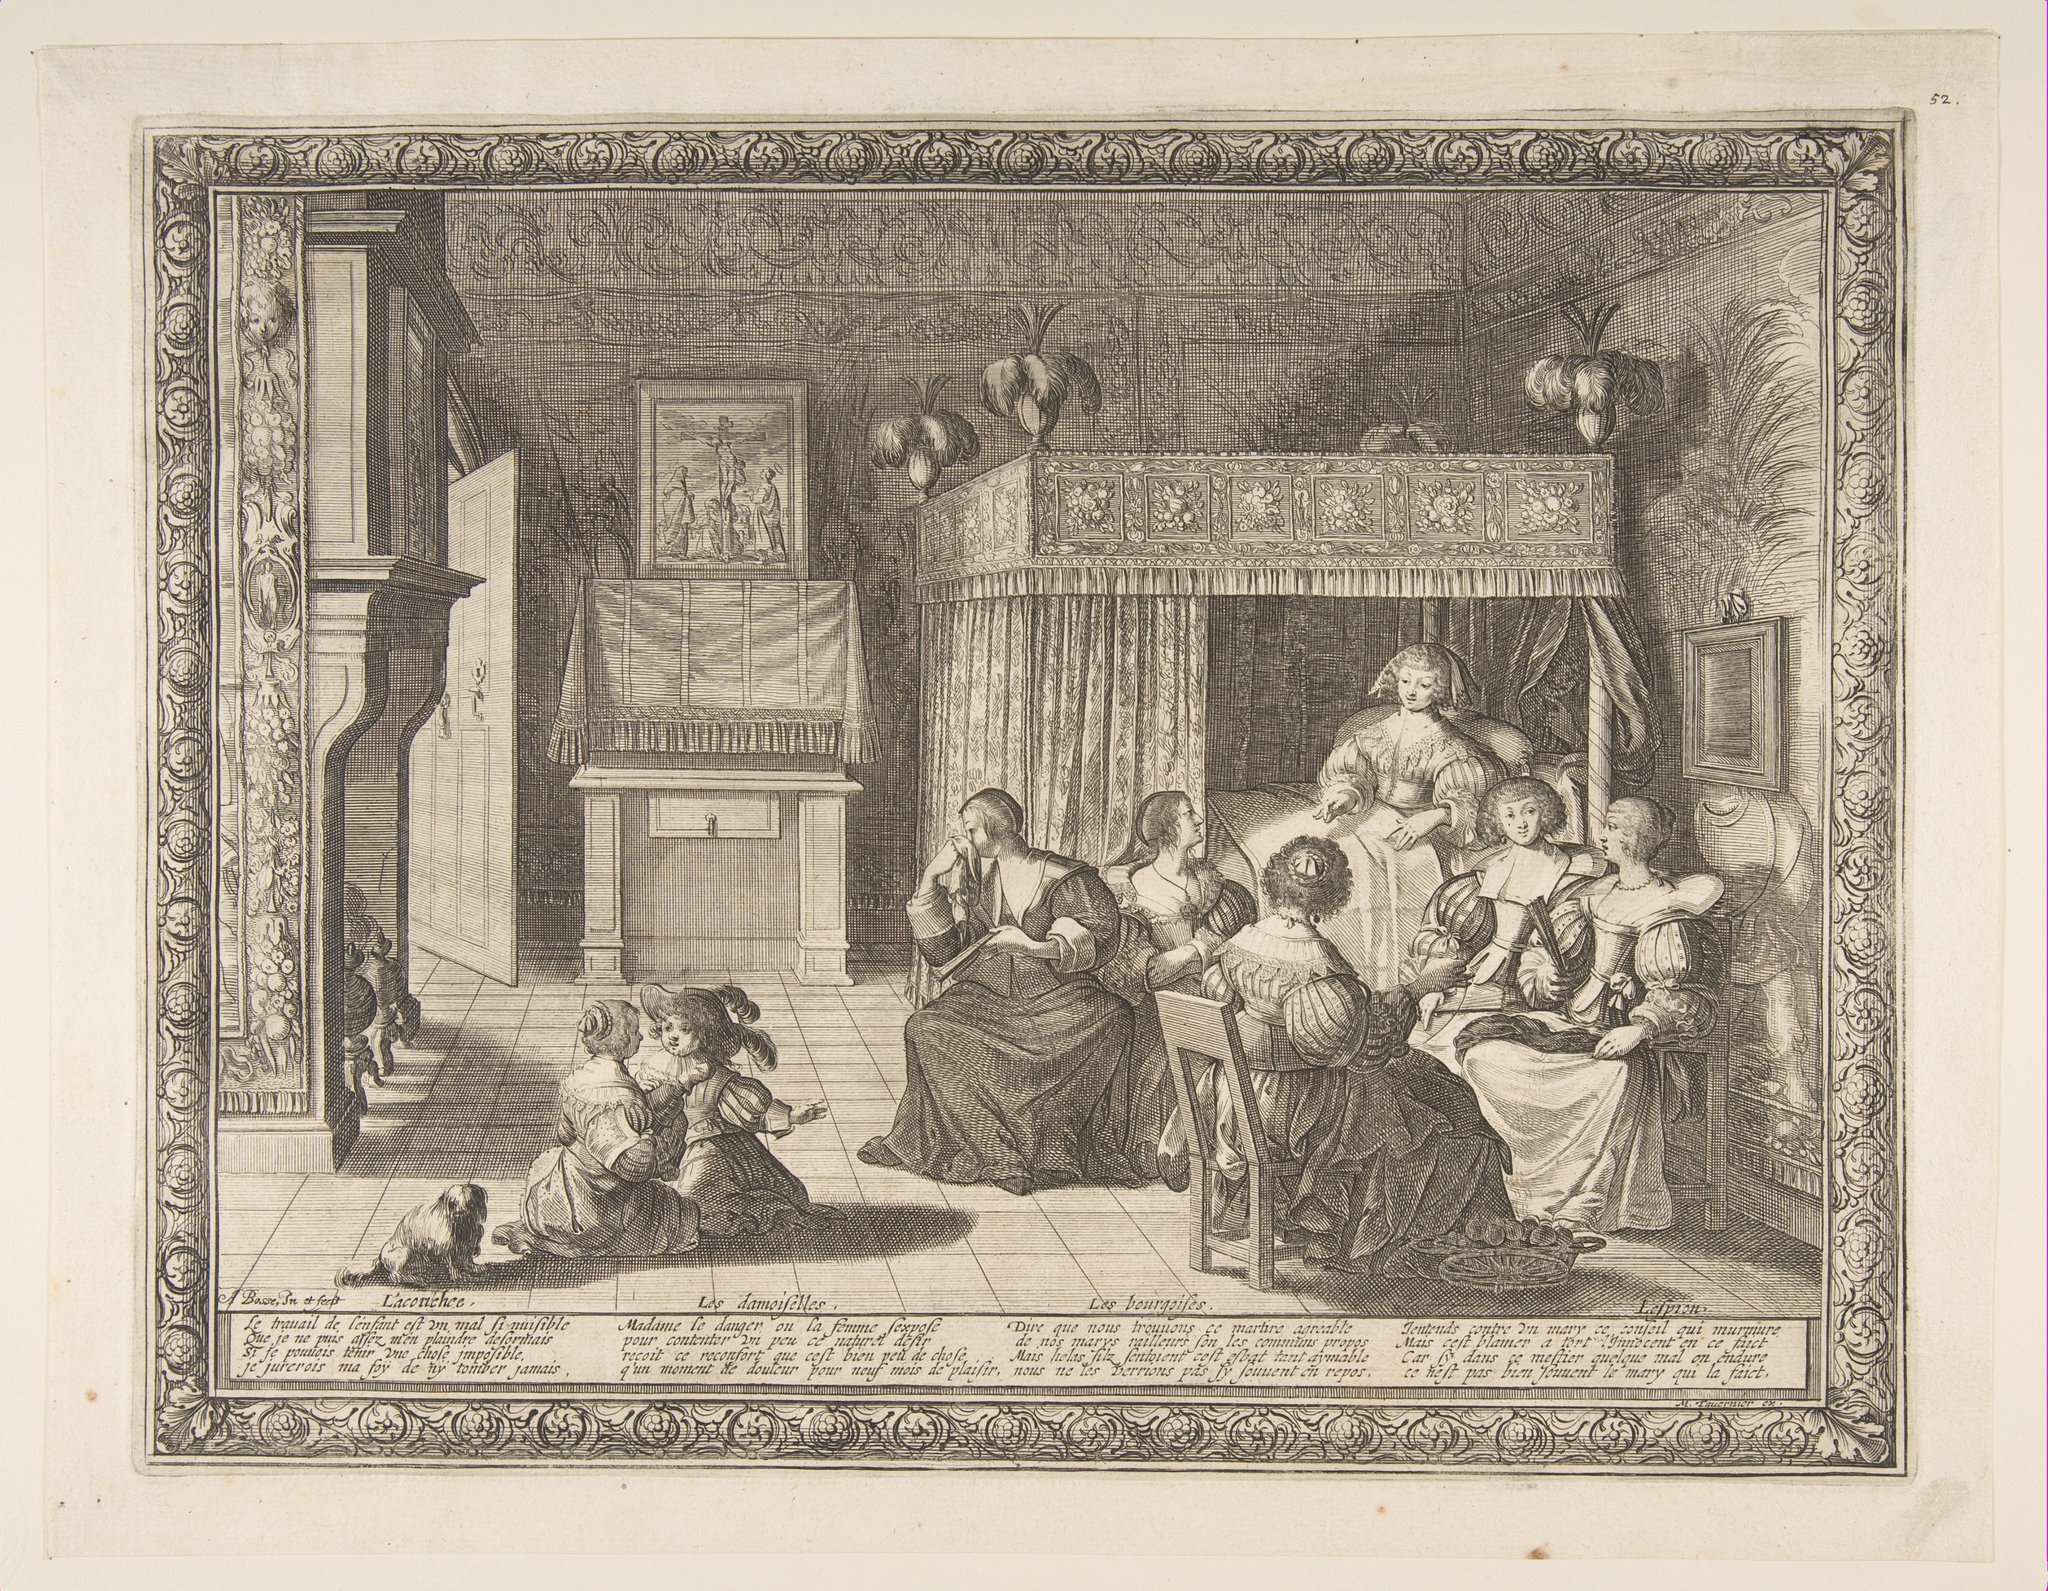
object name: print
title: Visit to the New Mother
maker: abraham bosse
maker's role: artist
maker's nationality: french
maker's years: 1602-1676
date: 1633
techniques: engraving, etching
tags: animals,girls,mothers,women